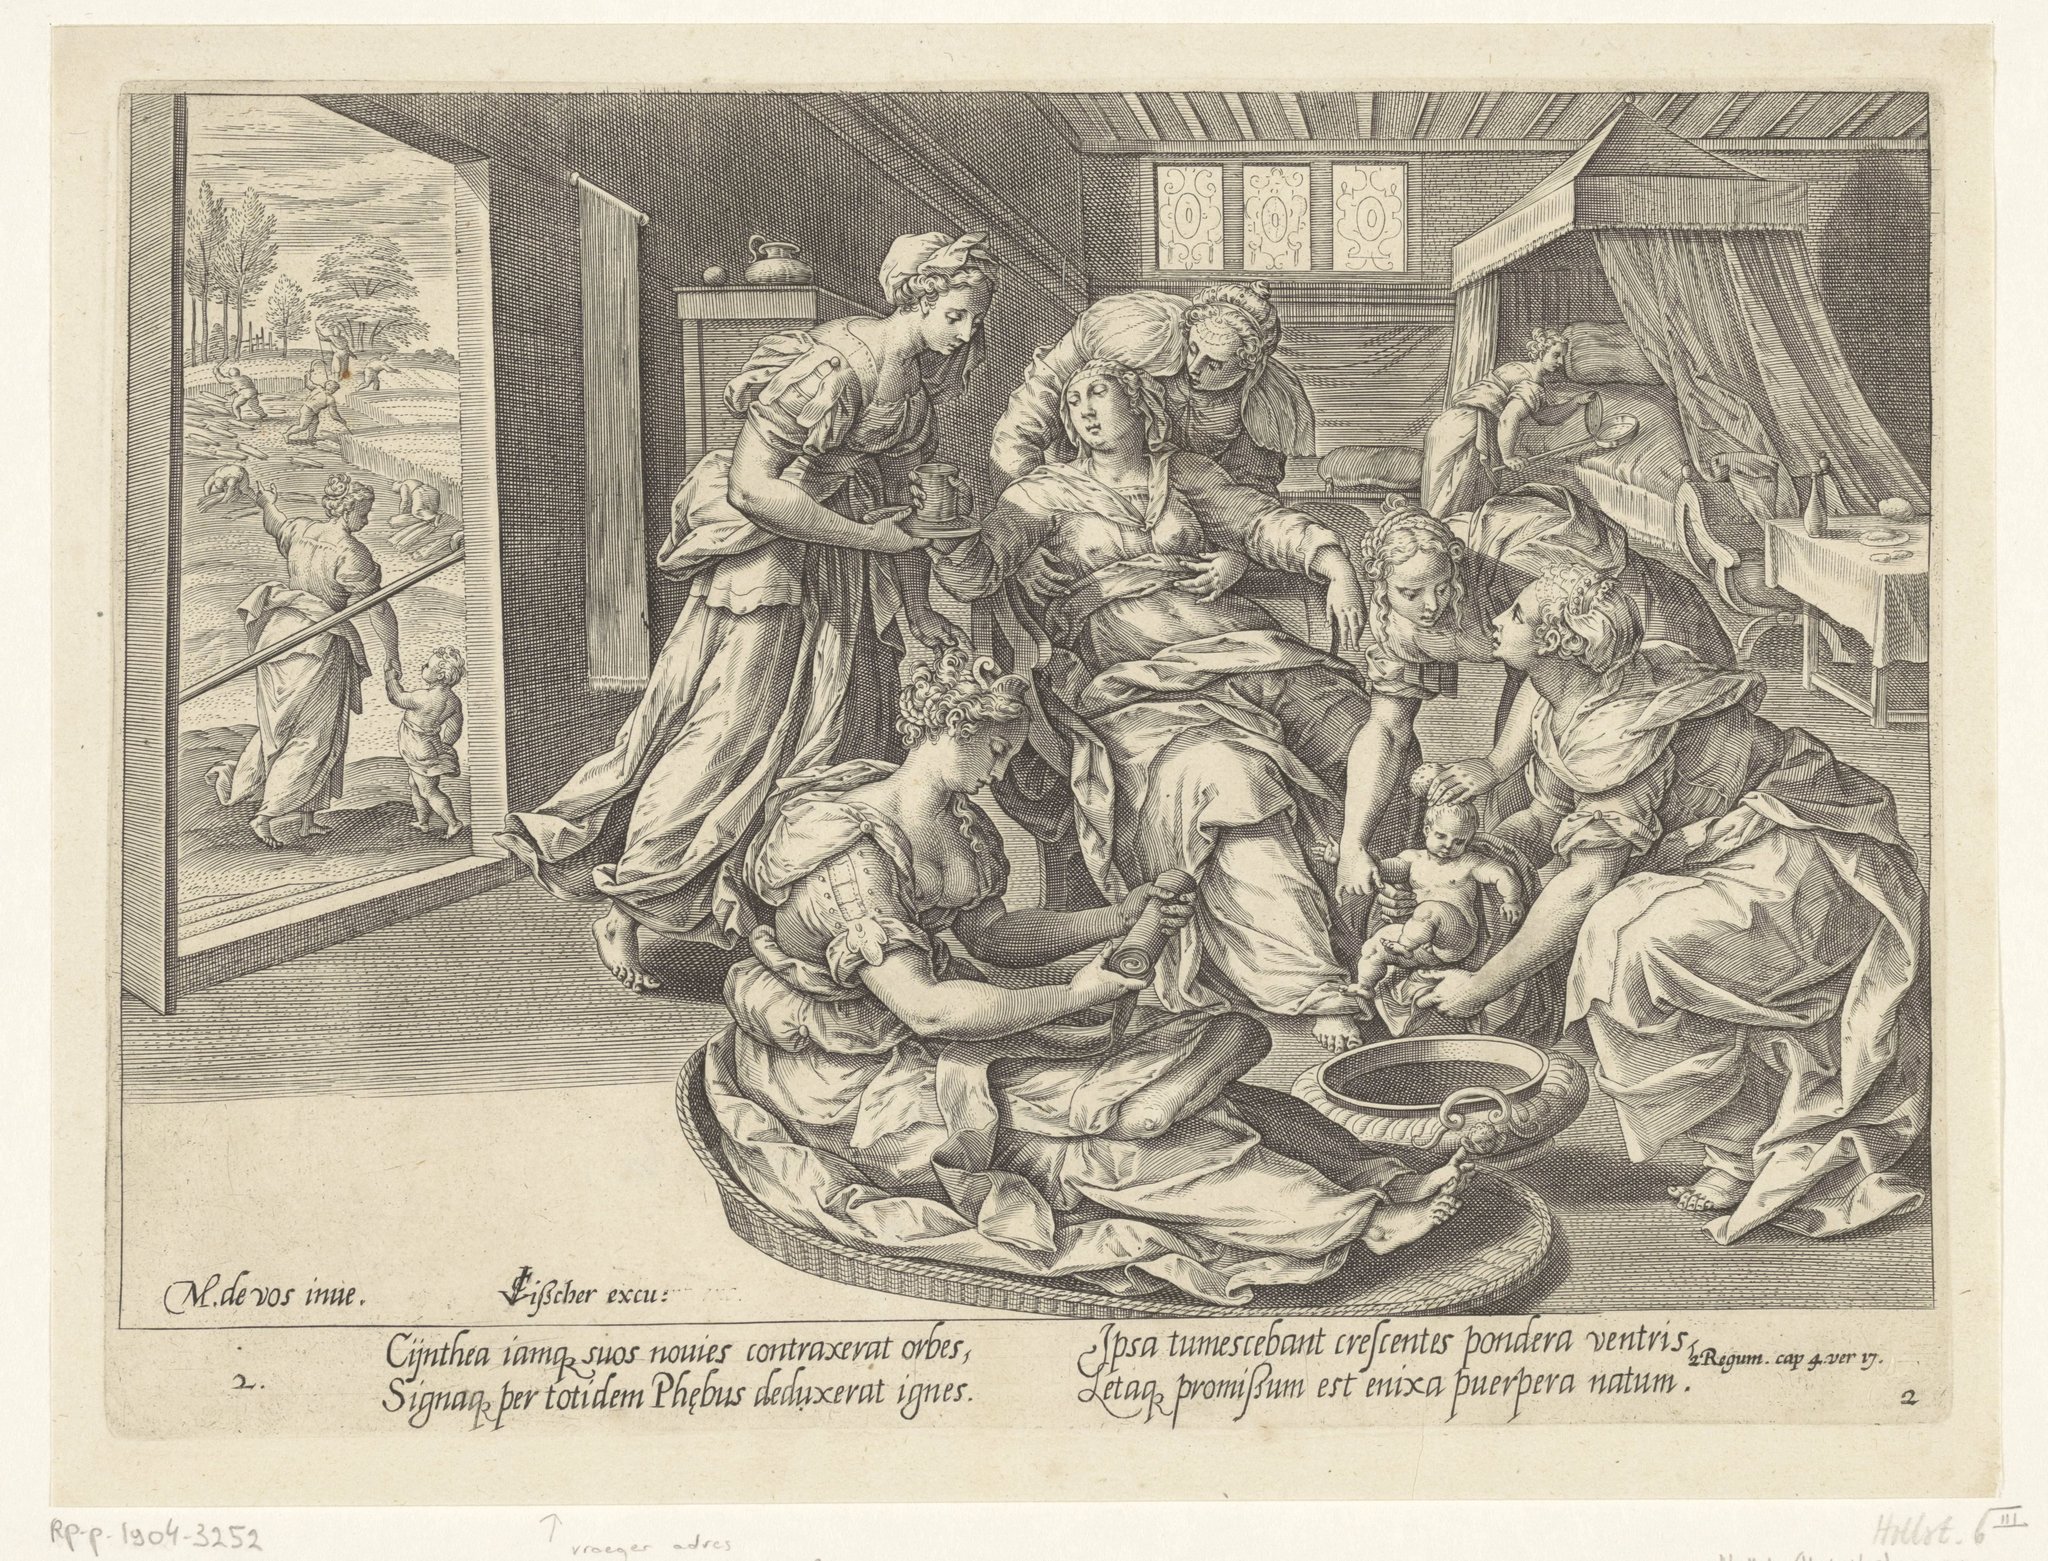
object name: print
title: Geboorte van de zoon van de Sunnemitische vrouw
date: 1643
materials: paper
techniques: engraving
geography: amsterdam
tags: birth of the son of the shunammite woman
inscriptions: collector's mark: Lugt 2228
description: Op de voorgrond baart de Sunnemitische vrouw een gezonde zoon. Op de achtergrond links gaat ze met haar kind kijken naar de maaiers op het veld. De prent heeft een Latijns onderschrift en maakt deel uit van een serie over Elisa en de Sunnemitische vrouw.